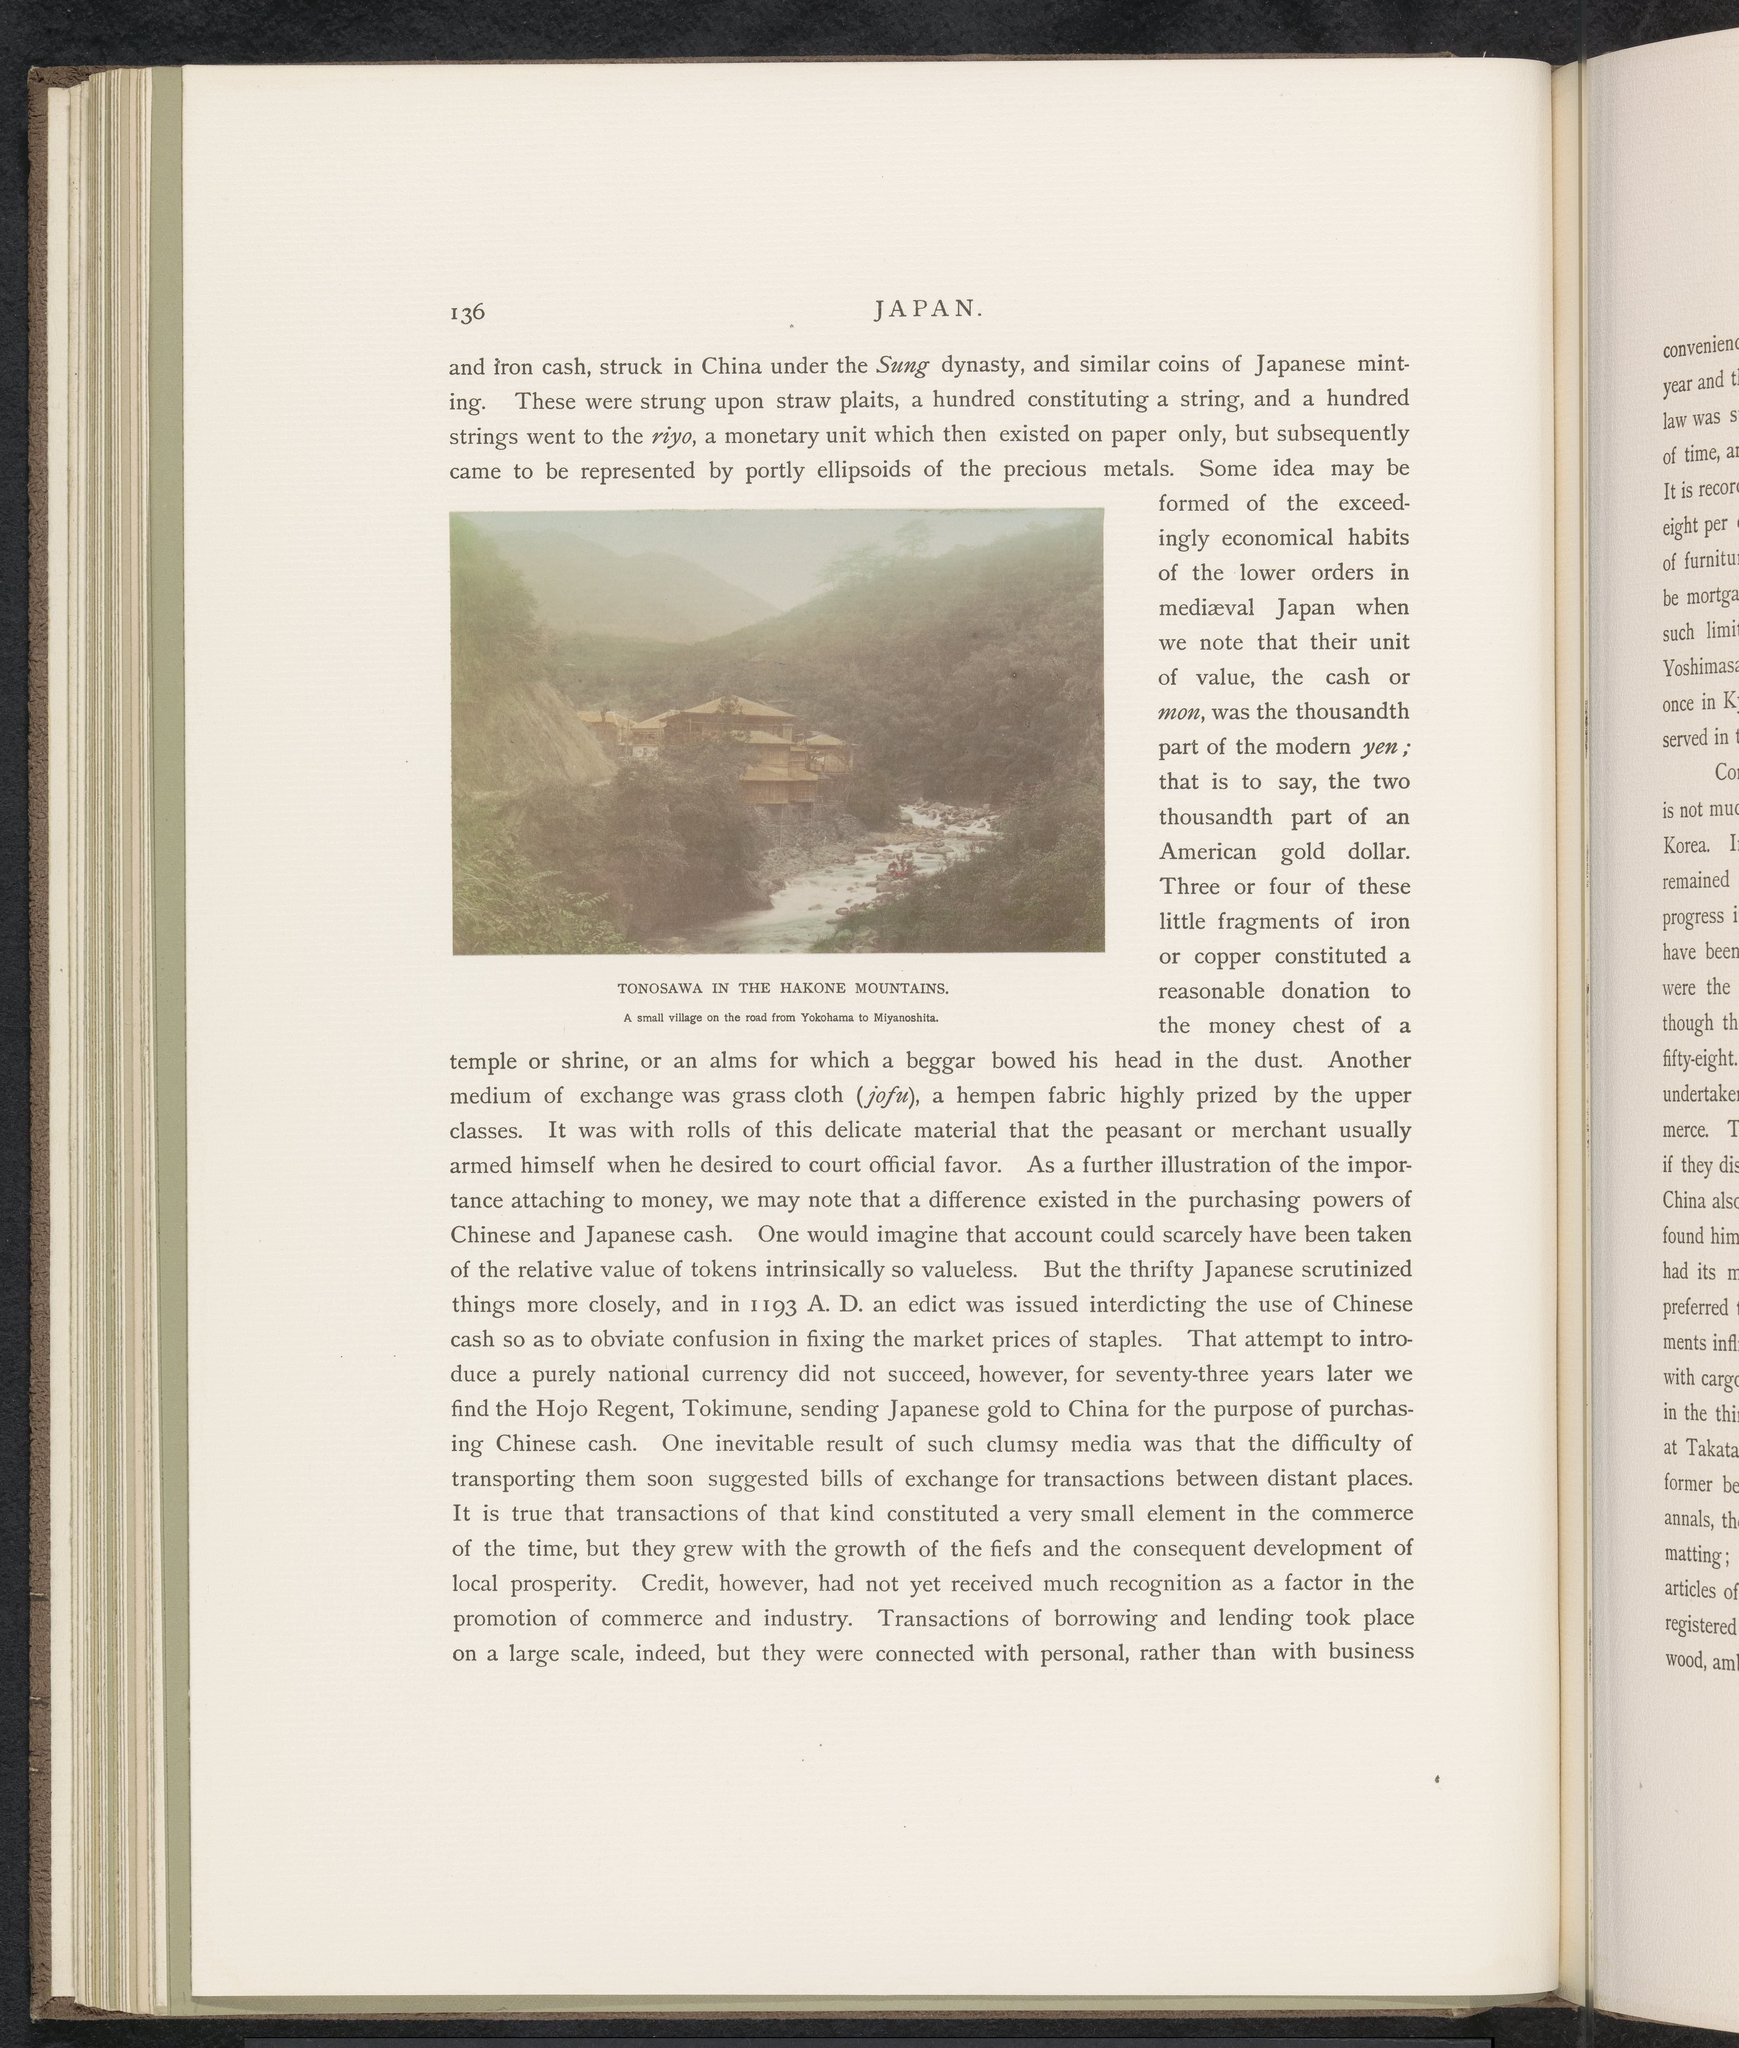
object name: page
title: Tonosawa in the Hakone mountains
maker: Anonymous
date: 1887-1897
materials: photographic support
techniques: albumen print, hand coloring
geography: japan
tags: city-view in general; 'veduta'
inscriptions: inscription: ‘A small village on the road from Yokohama to Miyanoshita.’